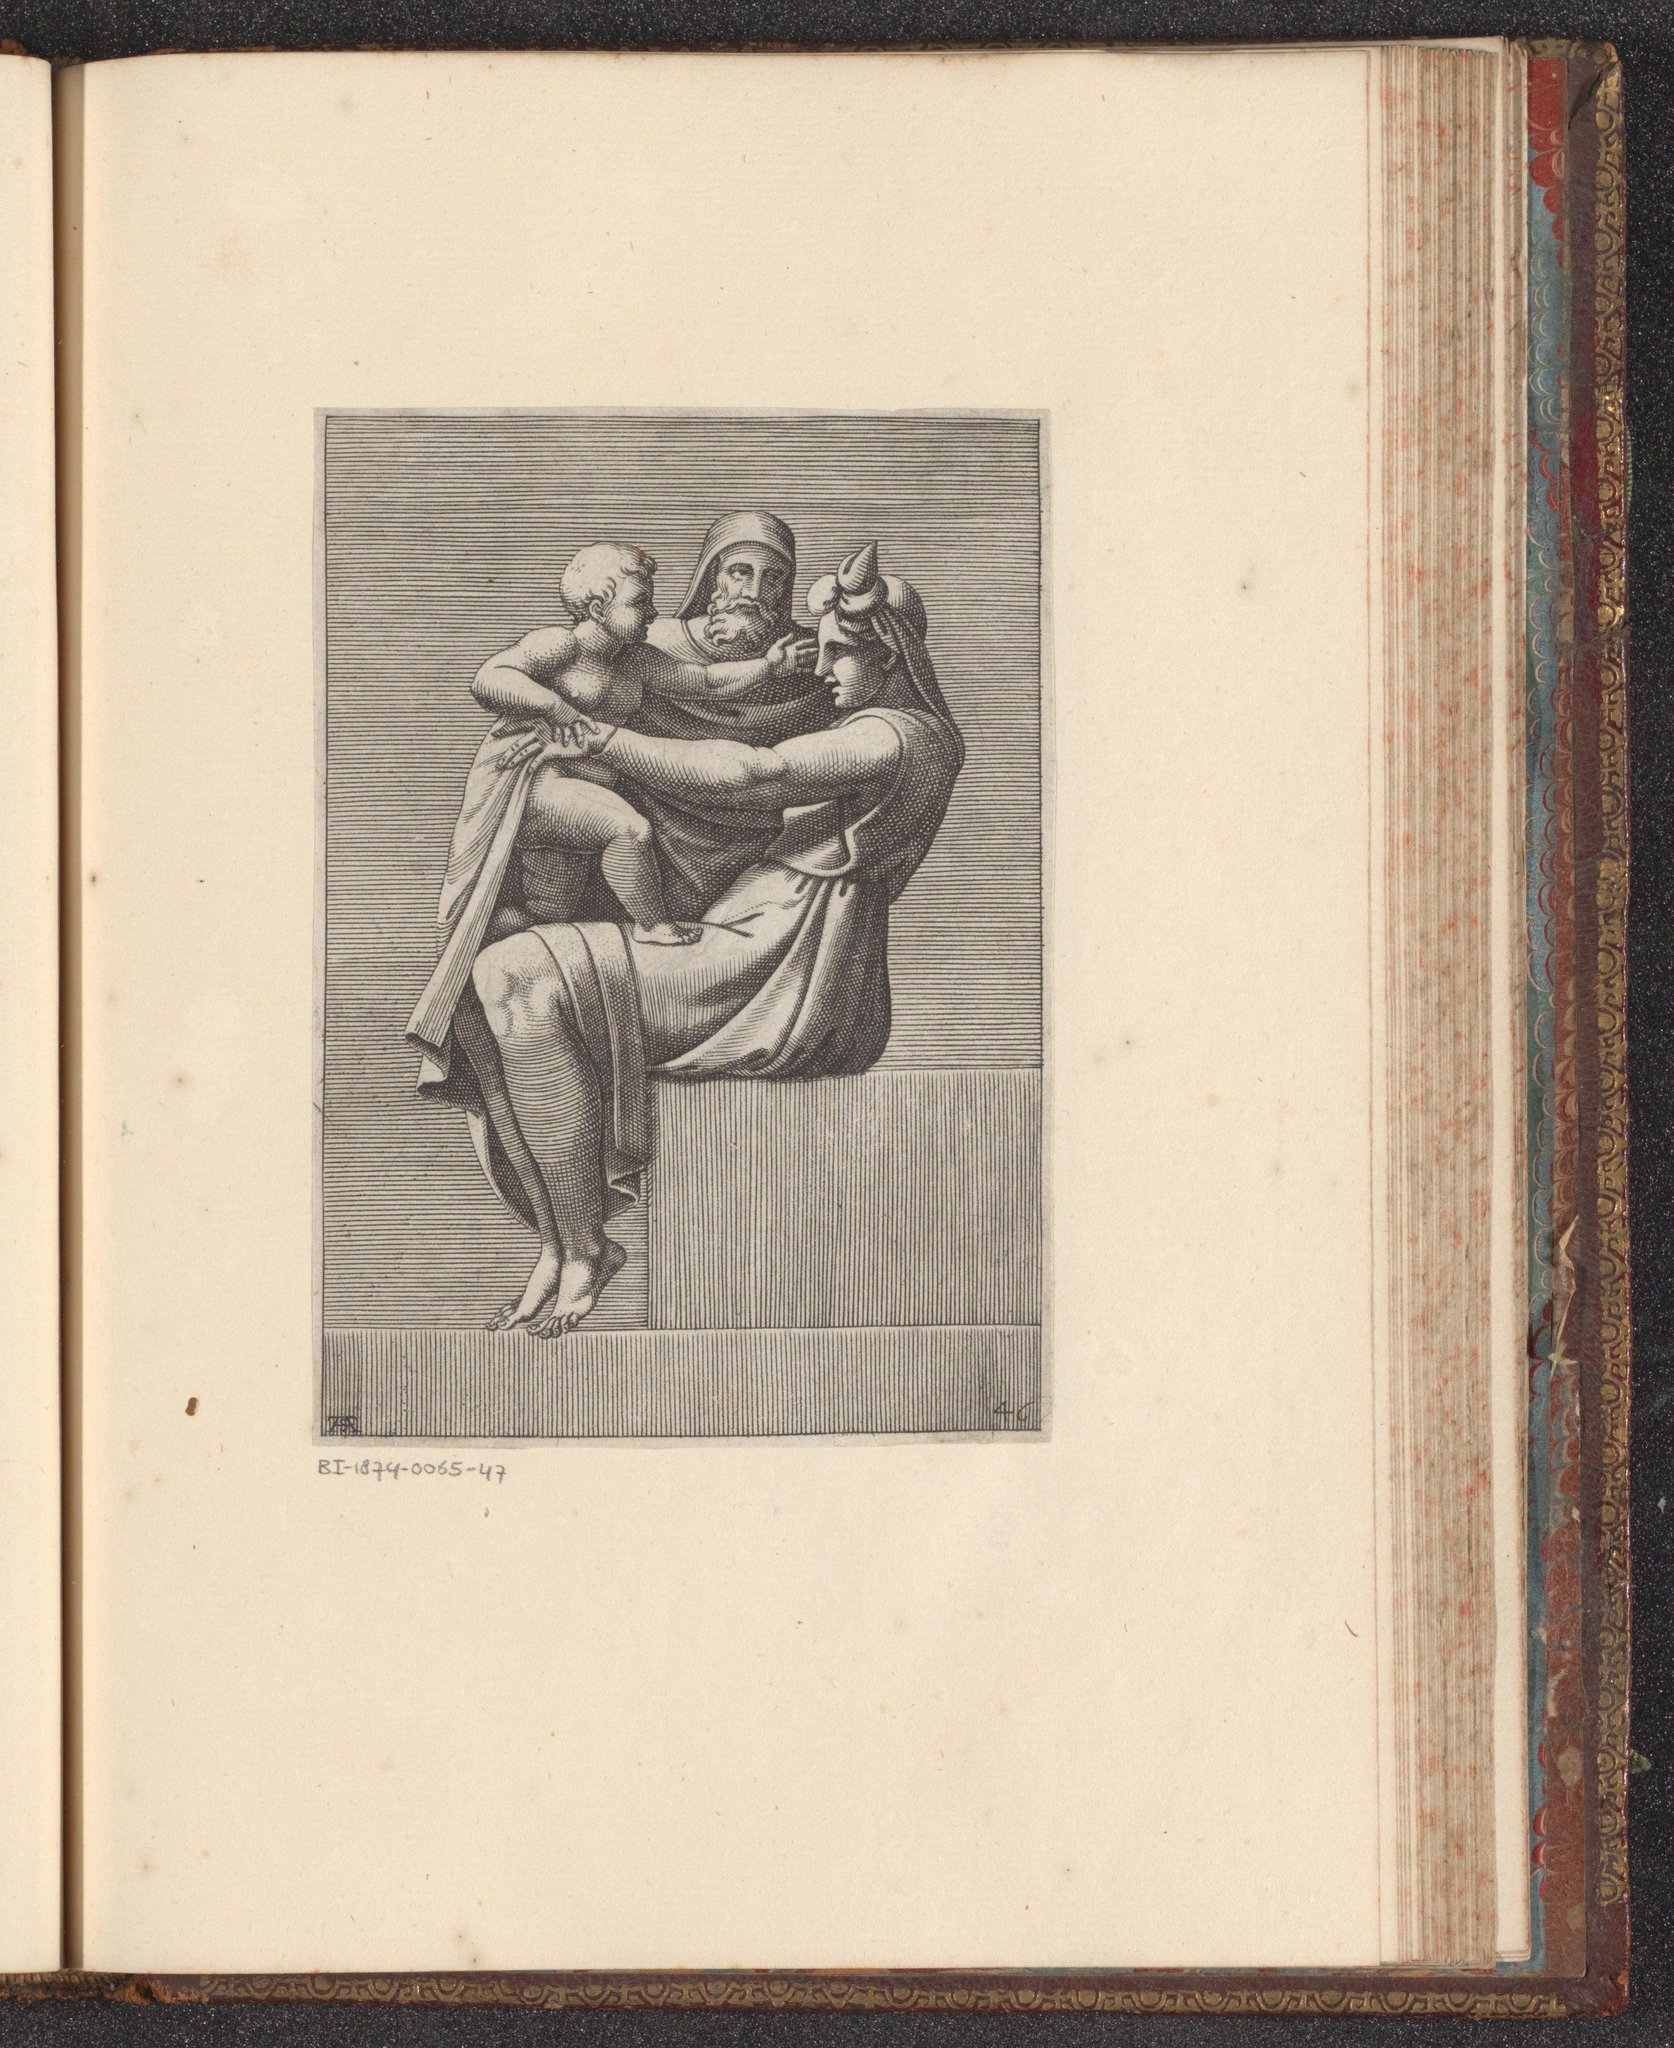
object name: album leaf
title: Zittende vrouw met kind en oude man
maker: adamo scultori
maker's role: painter, print maker, sculptor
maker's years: 1530-1585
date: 1585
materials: paper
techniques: engraving, intaglio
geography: vatican city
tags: mother and child(ren), woman and child(ren) (family group)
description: Deze prent maakt deel uit van een serie bestaande uit een titelprent en 72 prenten naar schilderingen door Michelangelo in de Sixtijnse Kapel in het Vaticaan.